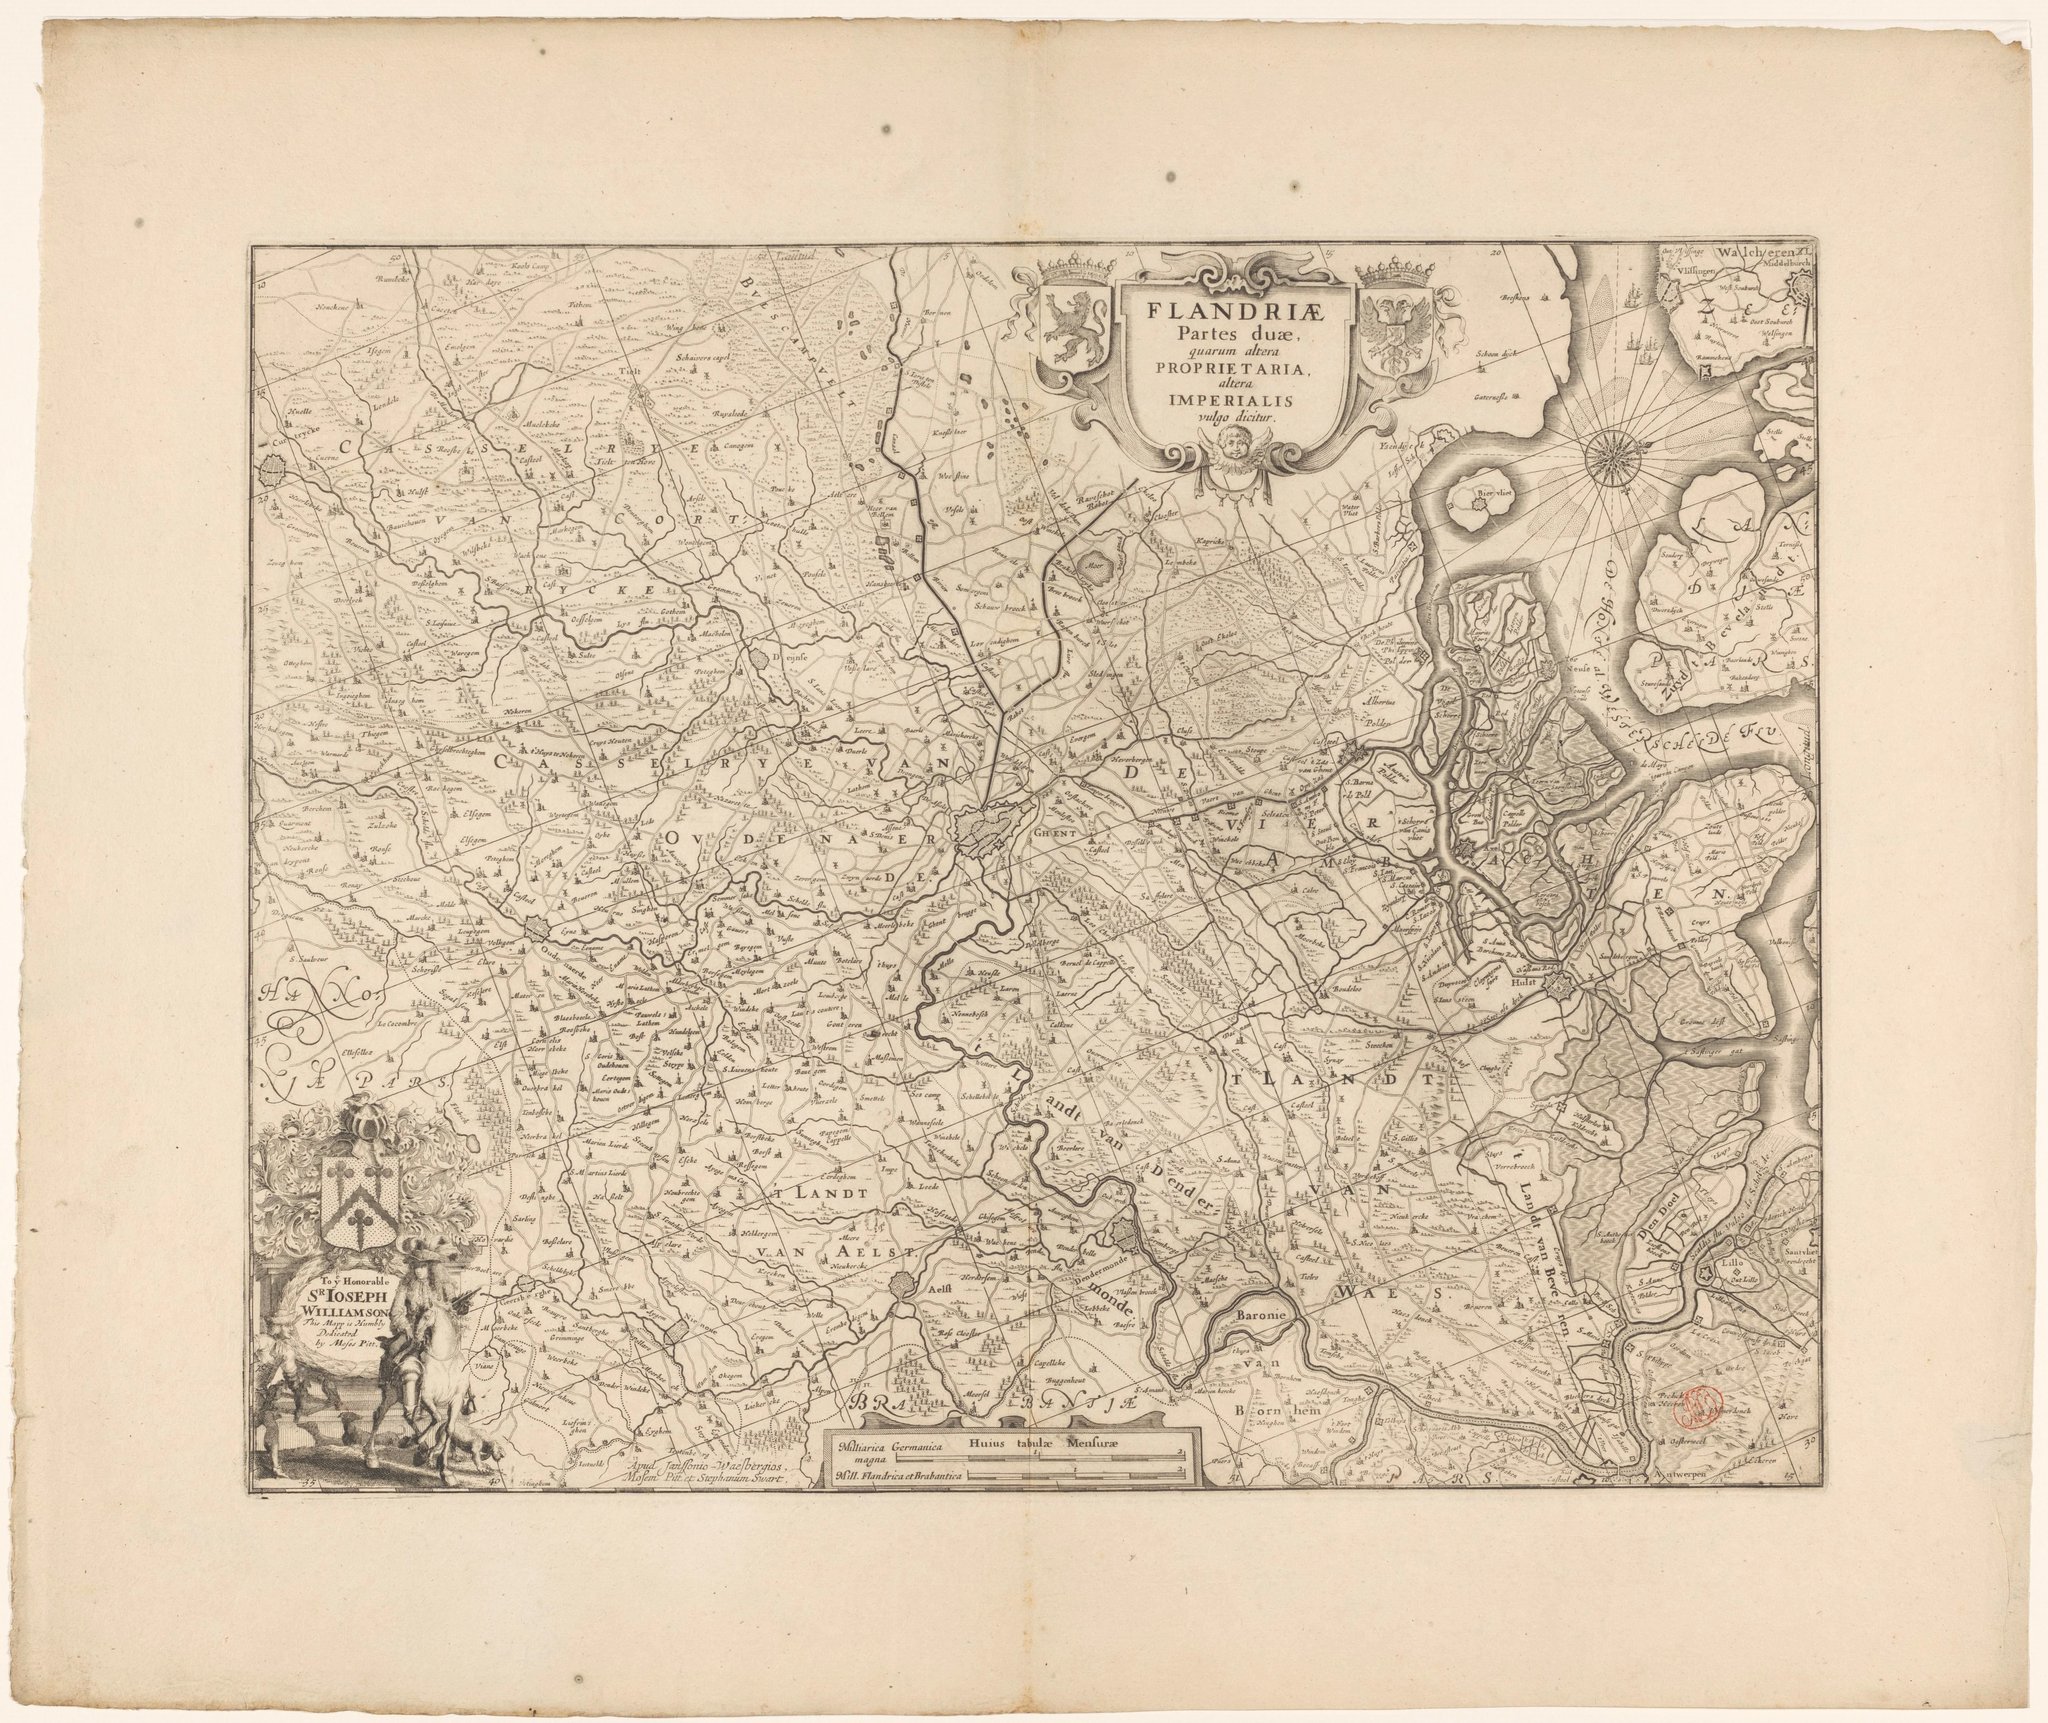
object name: print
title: Flandriae partes duae, quarum altera proprietaria, altera imperialis vulgo dicitur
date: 1641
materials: paper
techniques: engraving, etching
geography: oxford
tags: maps of separate countries or regions, coat of arms (as symbol of the state, etc.) (+ province; provincial), armorial bearing, heraldry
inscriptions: collector's mark: Lugt 195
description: Kaart van Eigenlijk en Rijks-Vlaanderen. Binnen het gebied dat tot het Heilig Roomse Rijk behoorde (Rijks-Vlaanderen), lagen ook de heerlijkheden Bornem, Dendermonde en Geraardsbergen, die in volledig bezit van de graaf van Vlaanderen waren en werden aangeduid als ‘Eigenlijk Vlaanderen’ of ‘Eigene’. Boven, rechts van het midden, de titelcartouche. Links van de cartouche het wapen van Vlaanderen. Rechts een wapenschild met de dubbelkoppige adelaar van het Heilig Roomse Rijk met daarop een hartschild met de Vlaamse leeuw. Linksonder een cartouche met opdracht aan Joseph Williamson, boven de cartouche zijn wapen. Onder, in het midden, een cartouche met twee schaalstokken: Milliarica Germanica magna / Mill. Flandrica et Brabantica. De kaart is voorzien van een coördinaten-net.